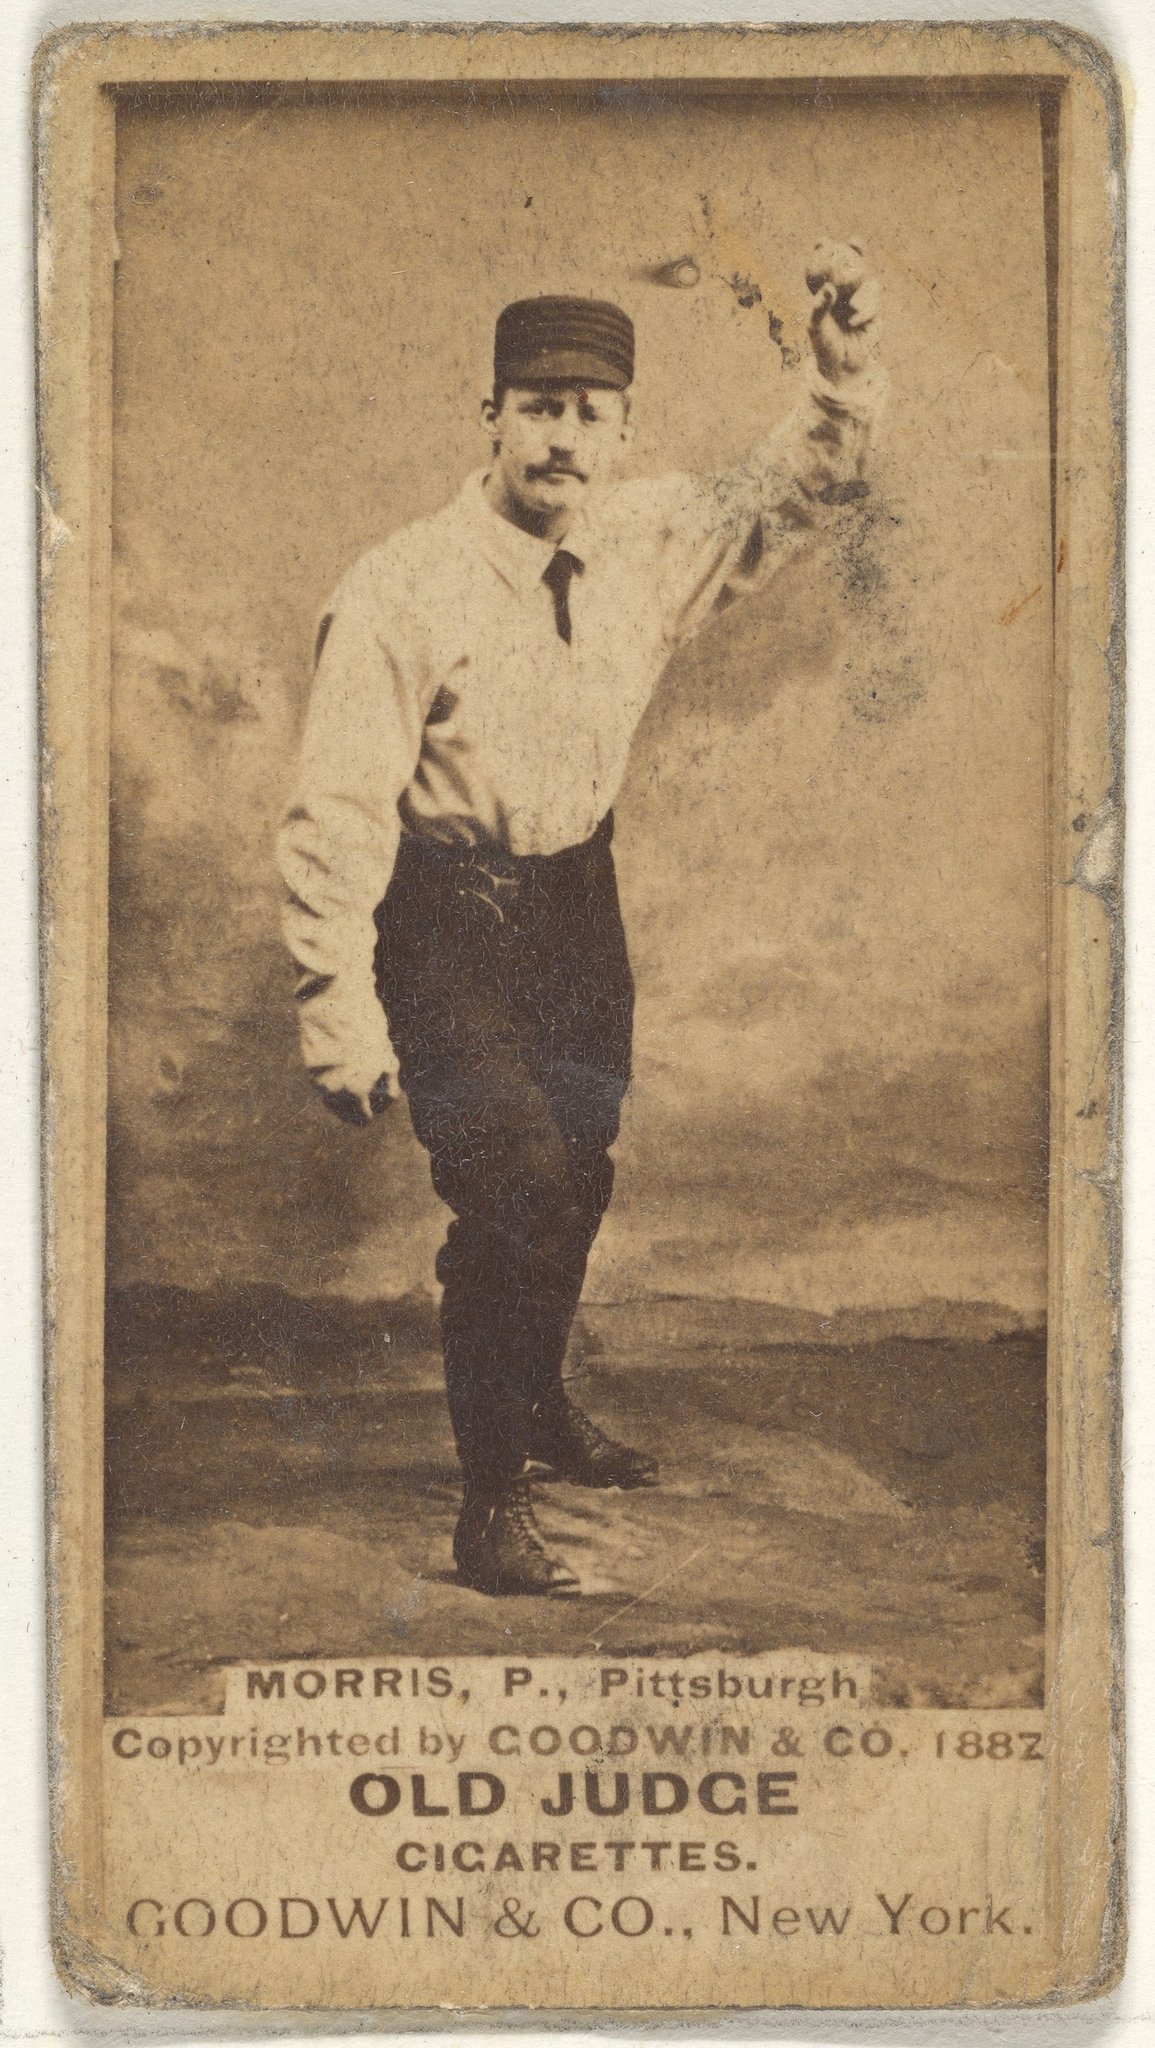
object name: baseball card, photograph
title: Ed Morris, Pitcher, Pittsburgh, from the Old Judge series (N172) for Old Judge Cigarettes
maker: goodwin & company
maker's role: publisher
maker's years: 1850-1950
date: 1887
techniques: albumen silver print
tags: men,portraits,baseball,athletes